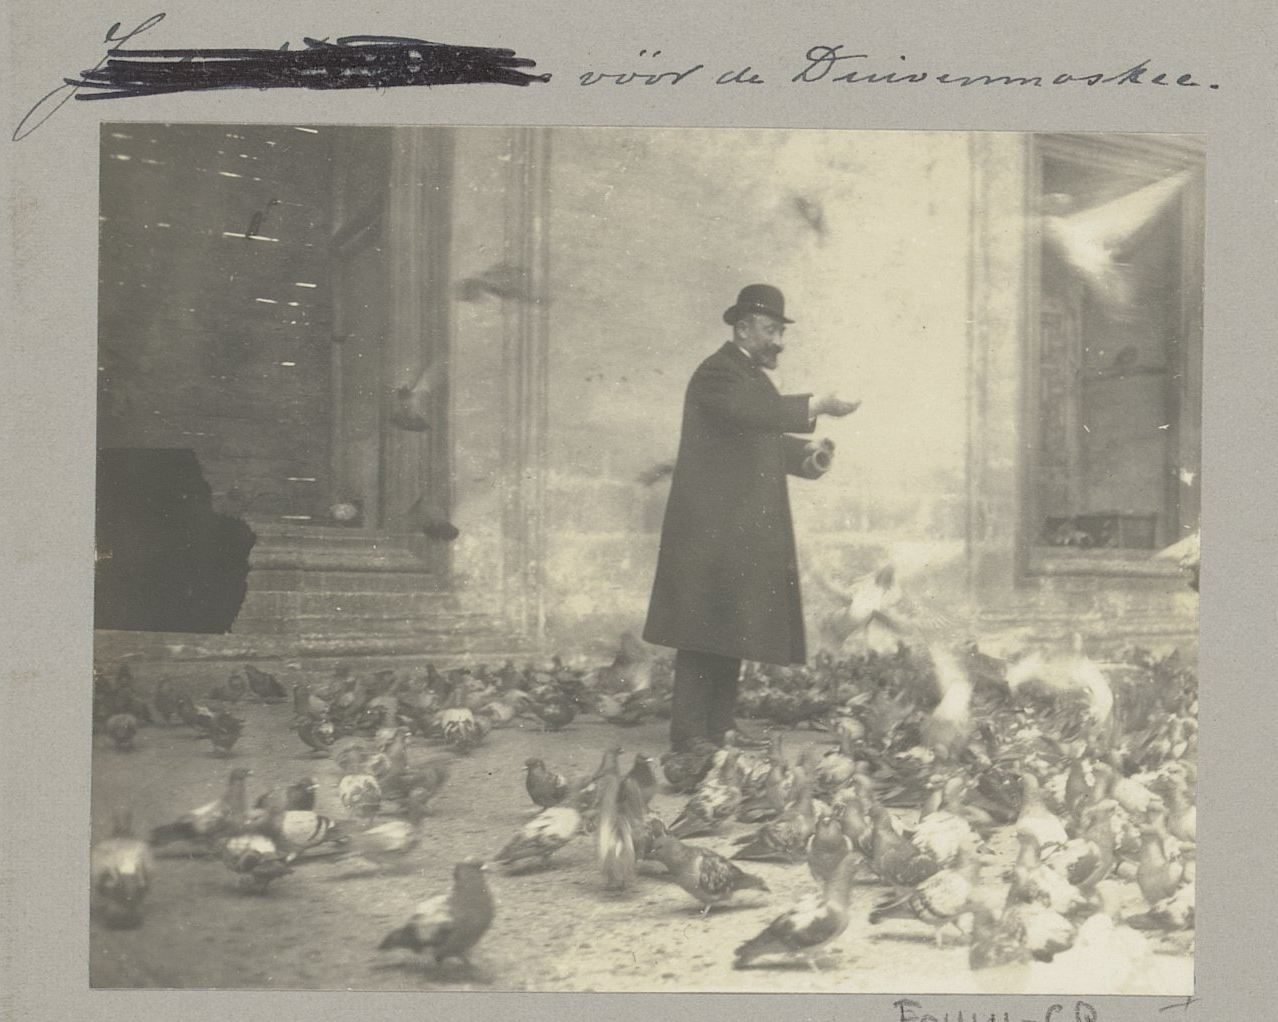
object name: photograph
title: Man met bolhoed voert duiven bij de Yeni Cami (Duivenmoskee) in Istanbul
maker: Anonymous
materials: photographic support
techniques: gelatin silver print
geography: istanbul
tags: doves, pigeons (+ feeding animal)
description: Onderdeel van Fotoalbum van een reis door Zuid-Europa en het Midden-Oosten.